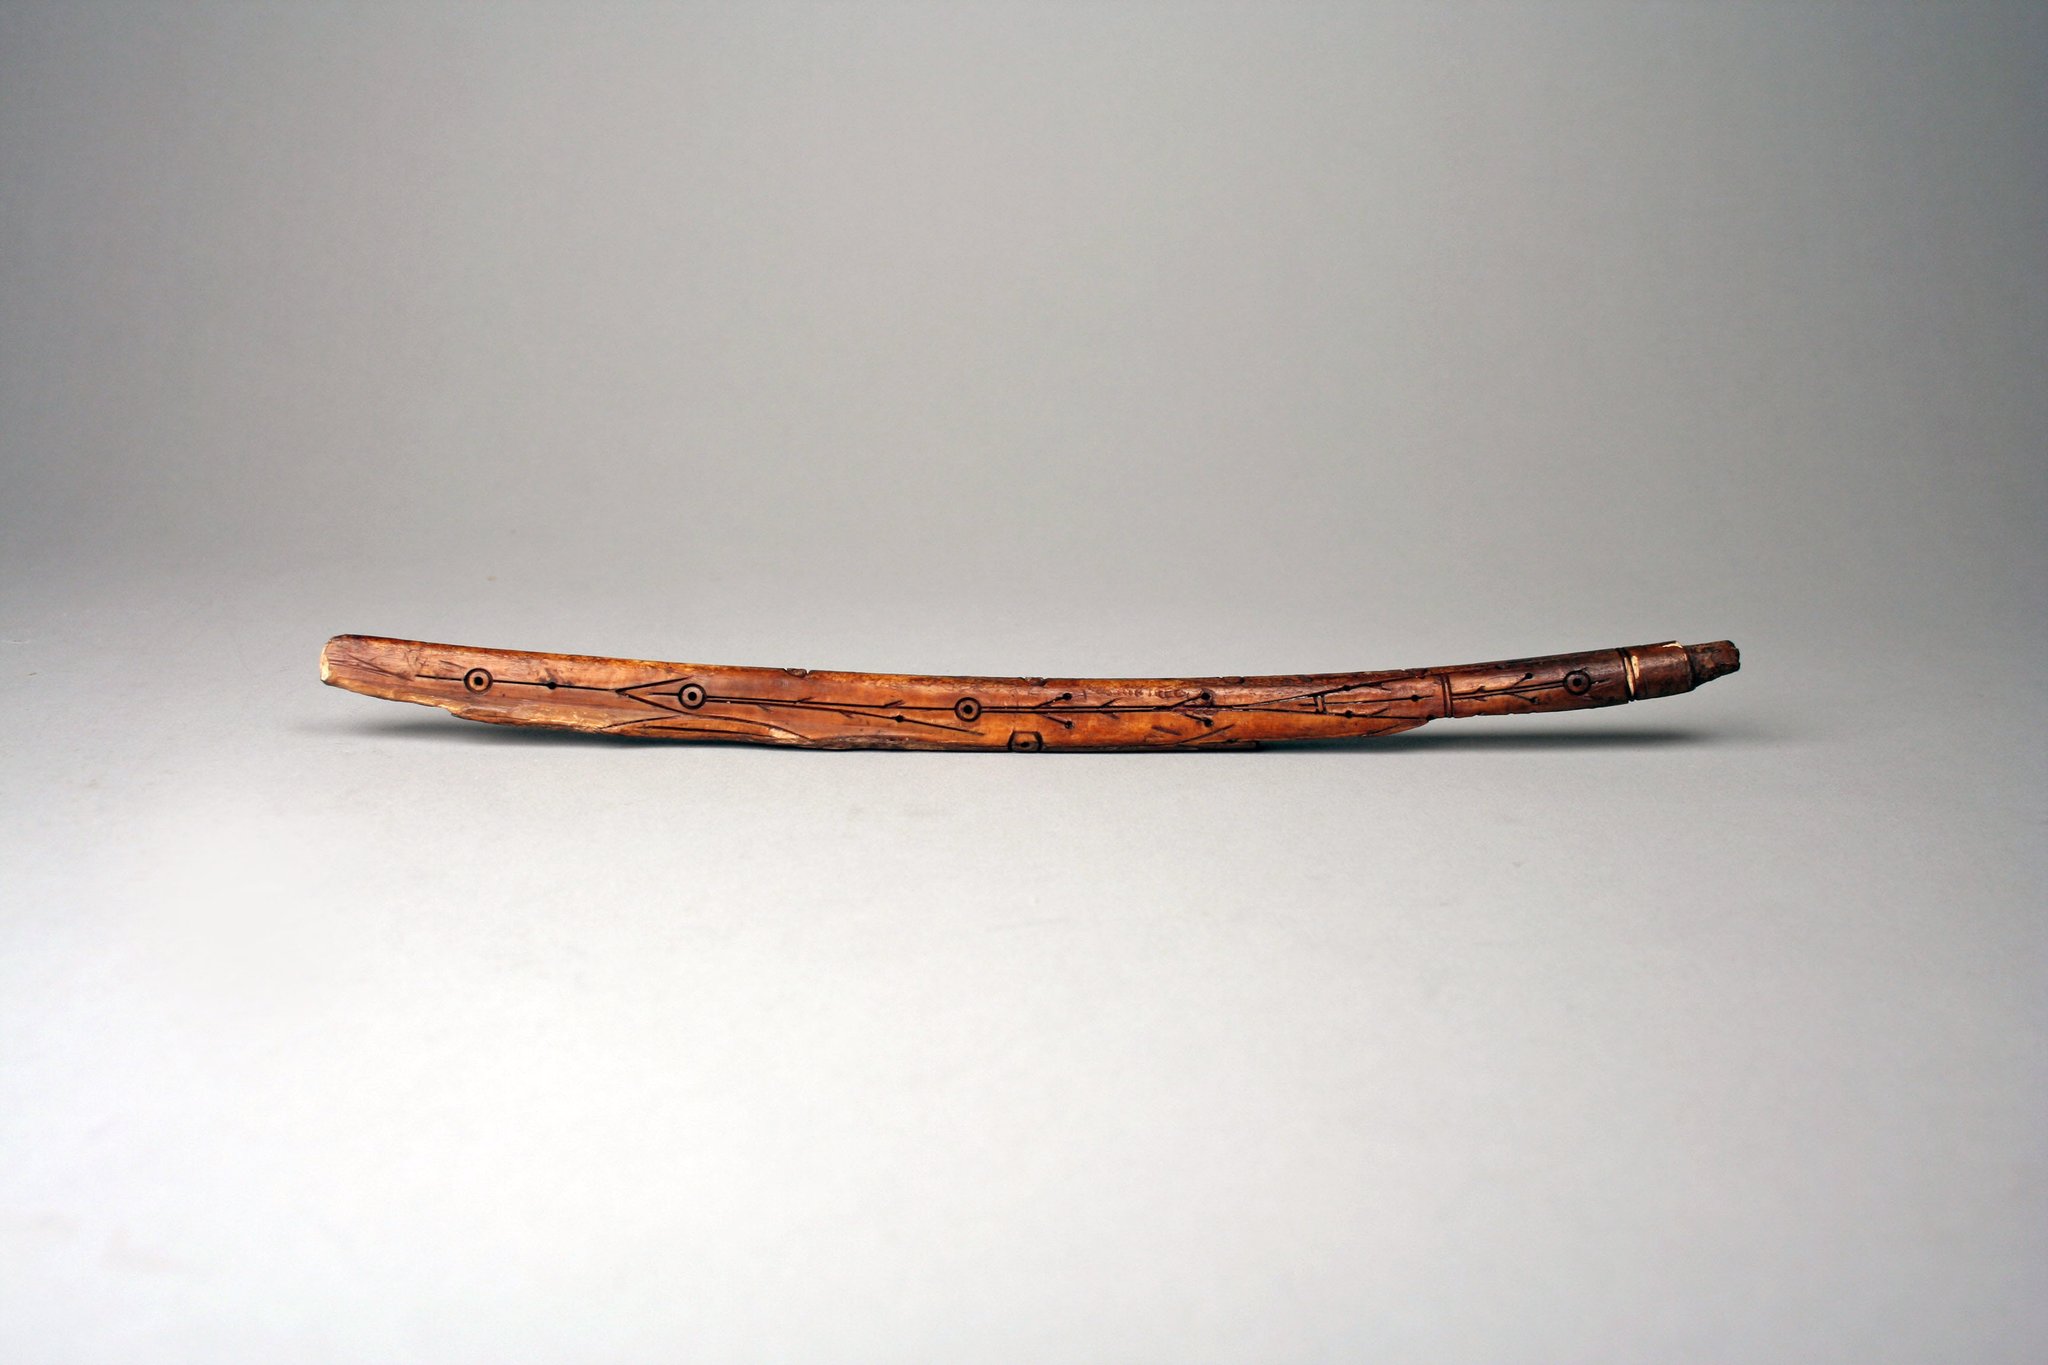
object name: dart socket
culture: punuk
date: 901-1000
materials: ivory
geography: united states